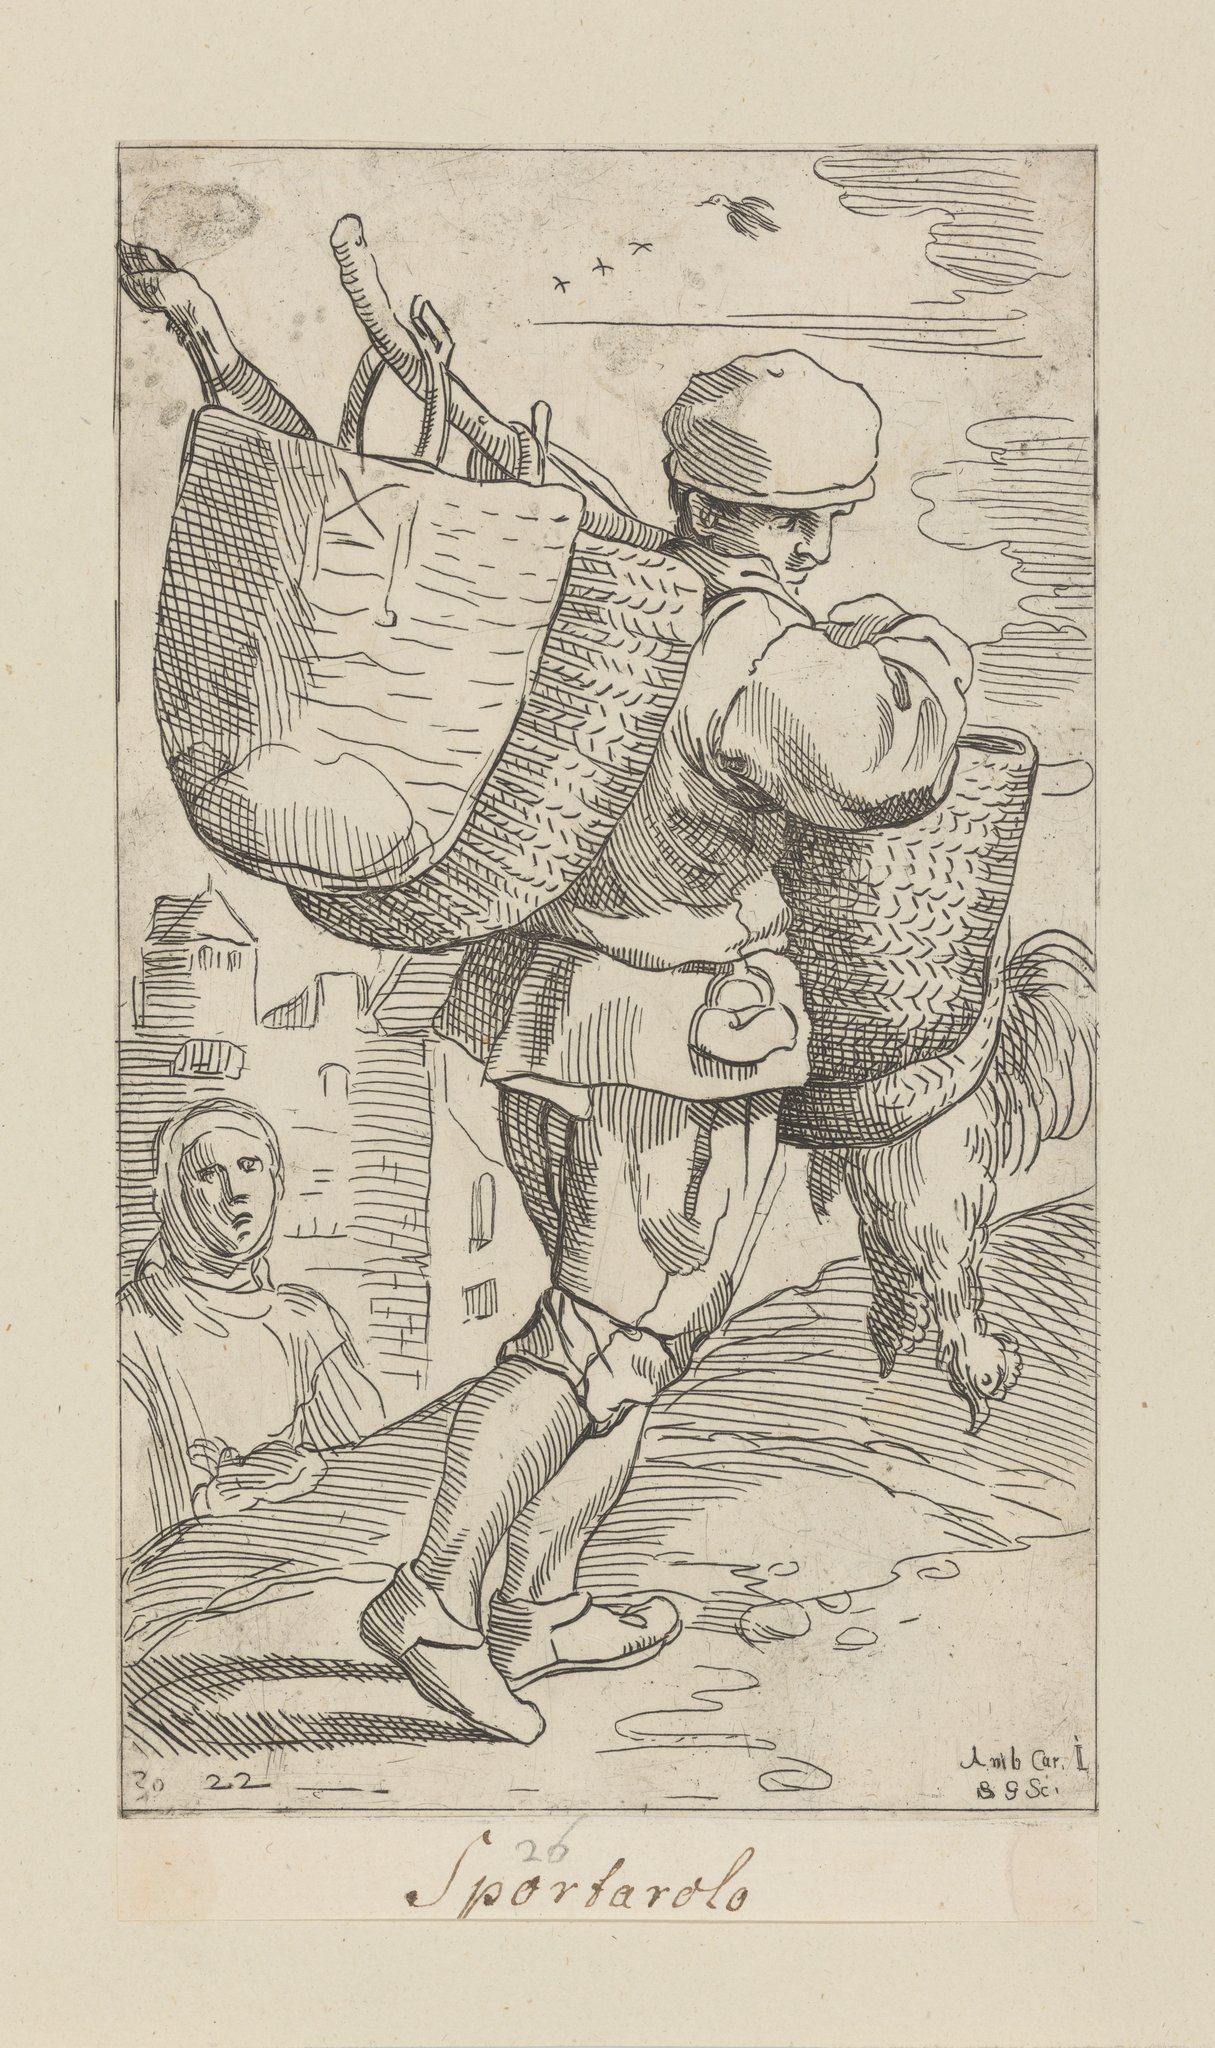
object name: print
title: Plate 22: Basket vendor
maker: simon guillain ii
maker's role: artist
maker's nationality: french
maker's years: 1618-1718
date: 1646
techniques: etching